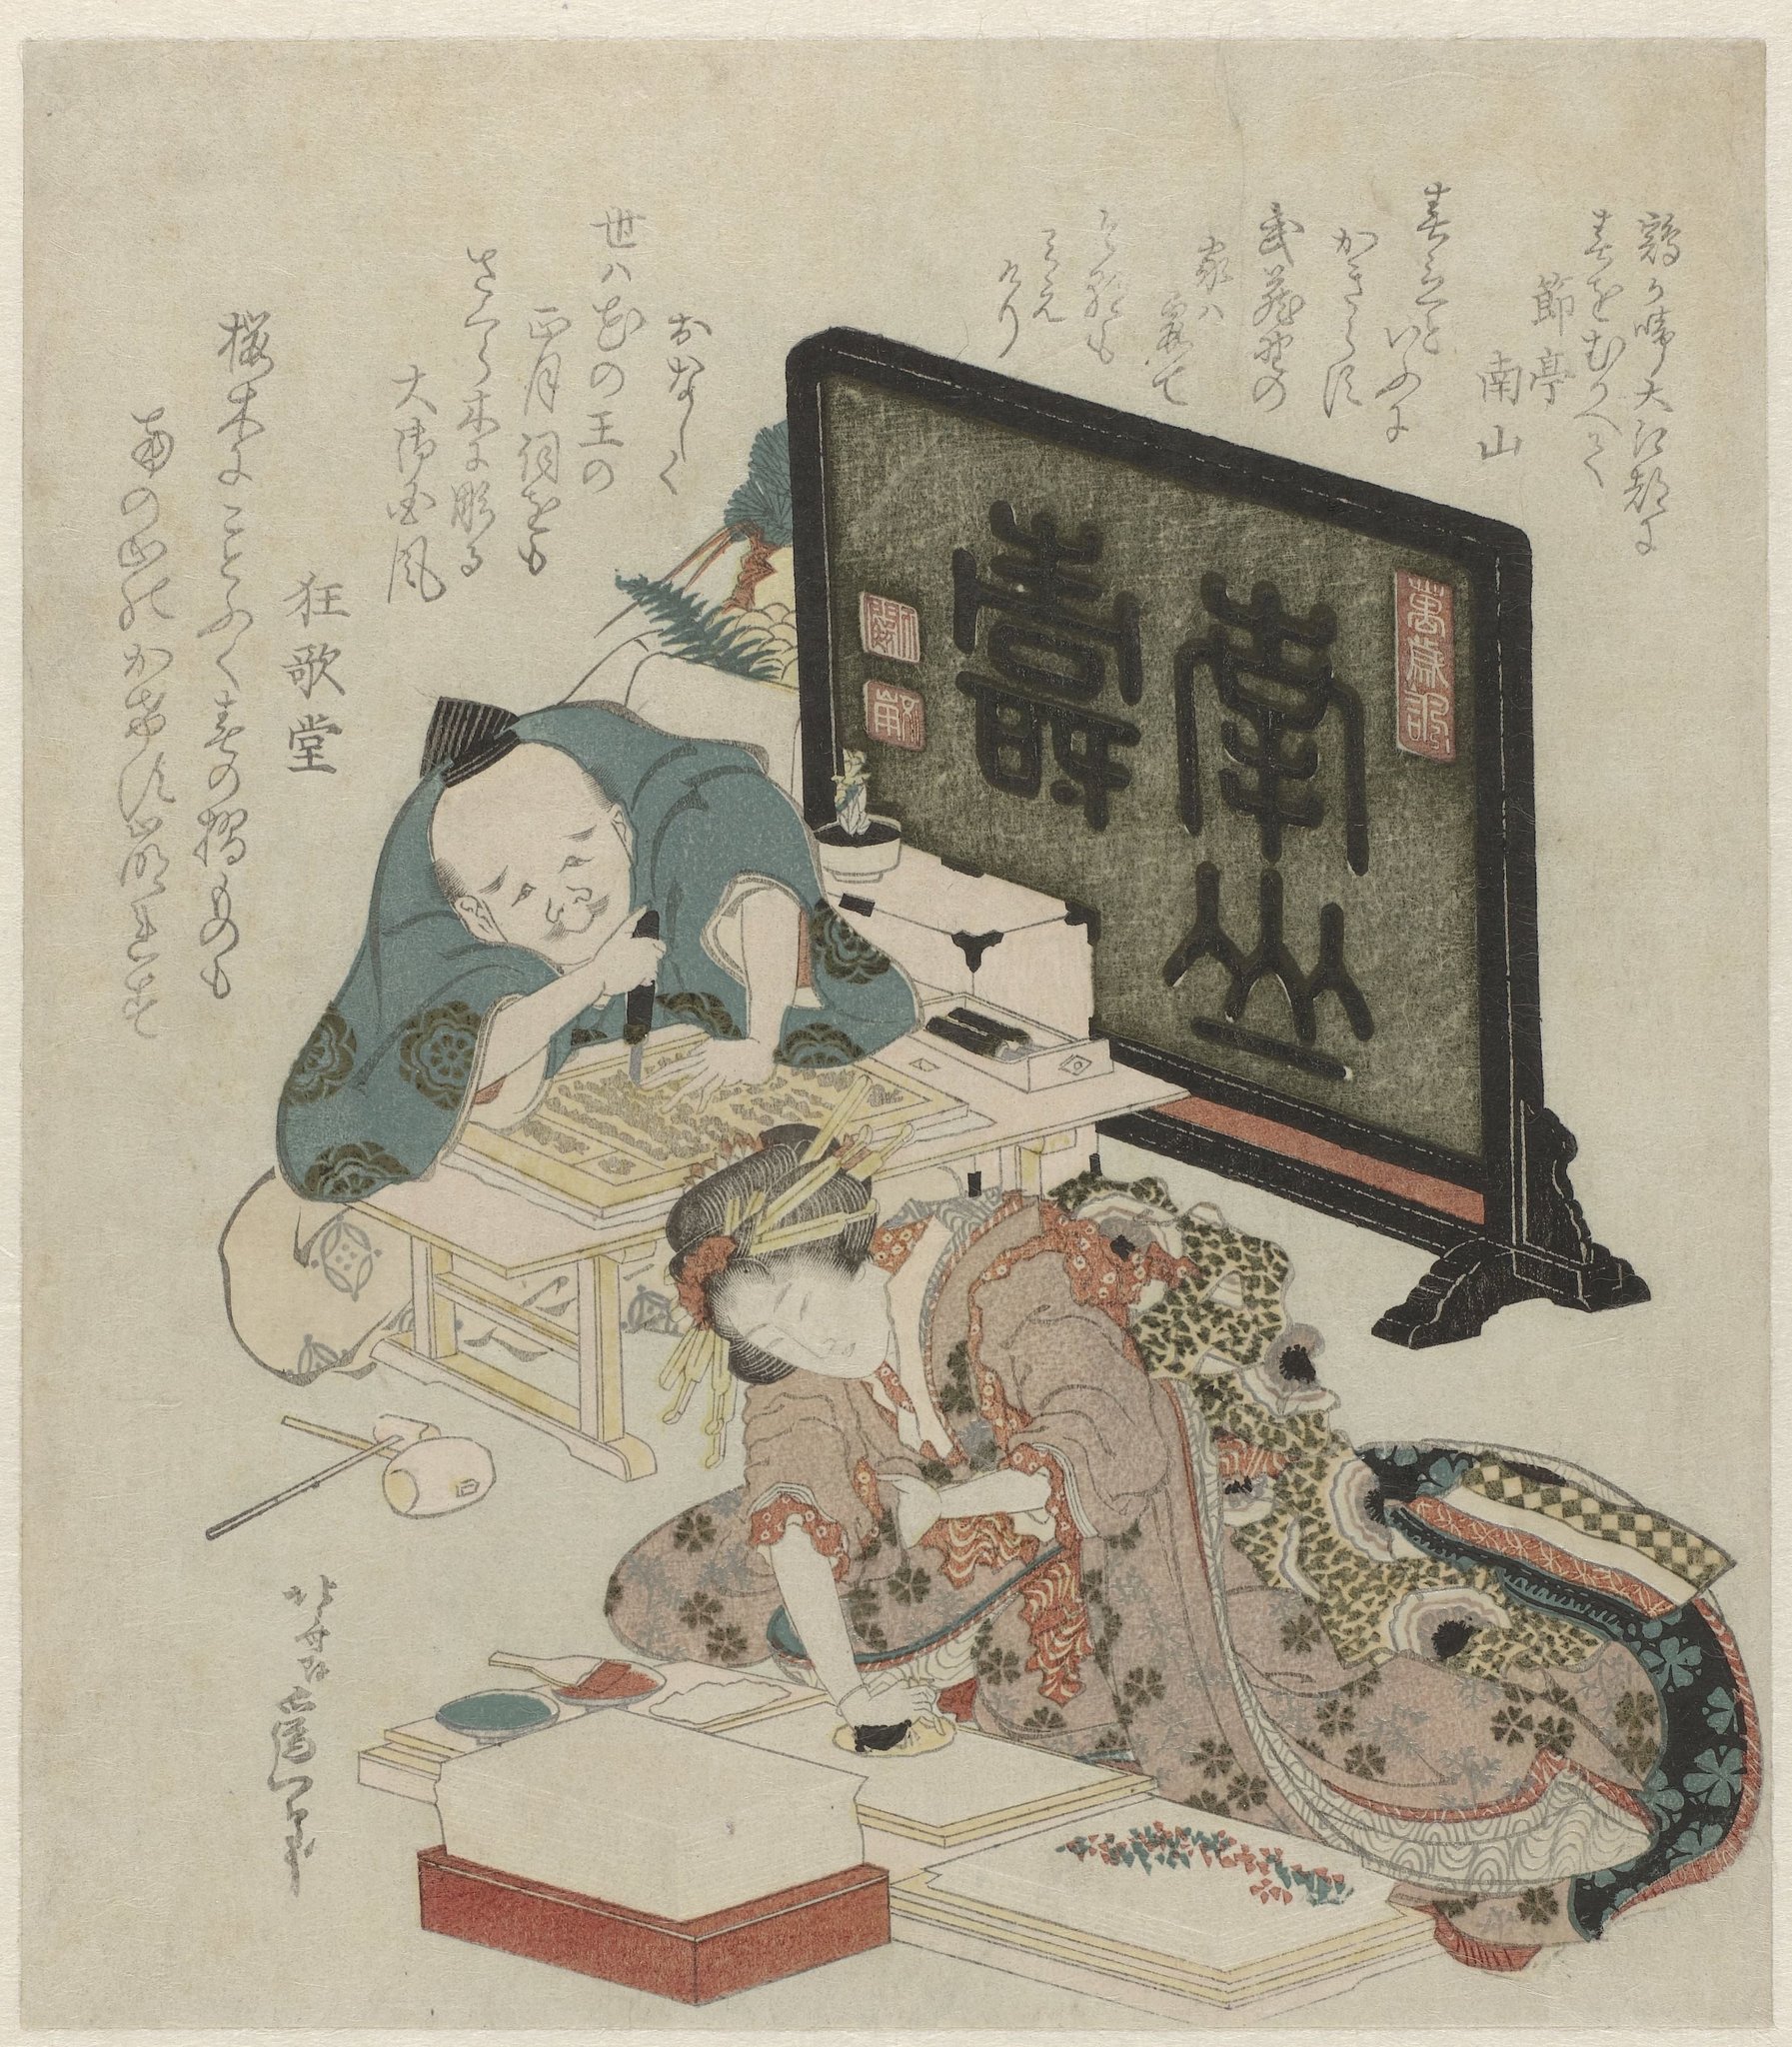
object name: print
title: Surimono maken voor Nieuwjaar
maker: katsushika hokusai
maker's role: draughtsman, print maker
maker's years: 1760-1849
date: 1825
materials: paper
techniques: woodcut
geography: edo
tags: print, e.g.: engraving, etching, lithograph, persons ~ printing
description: Een surimono is een luxe uitgevoerde prent waarop beeld met één of meerdere gedichten gecombineerd is. Bij het drukken van een surimono werd vaak gebruik gemaakt van dikker papier, blinddruk en metaal pigmenten, zoals koper- en zilverpoeder. De prenten werden vaak in opdracht van dichters gemaakt en als exclusief geschenk aan vrienden en relaties gegeven.